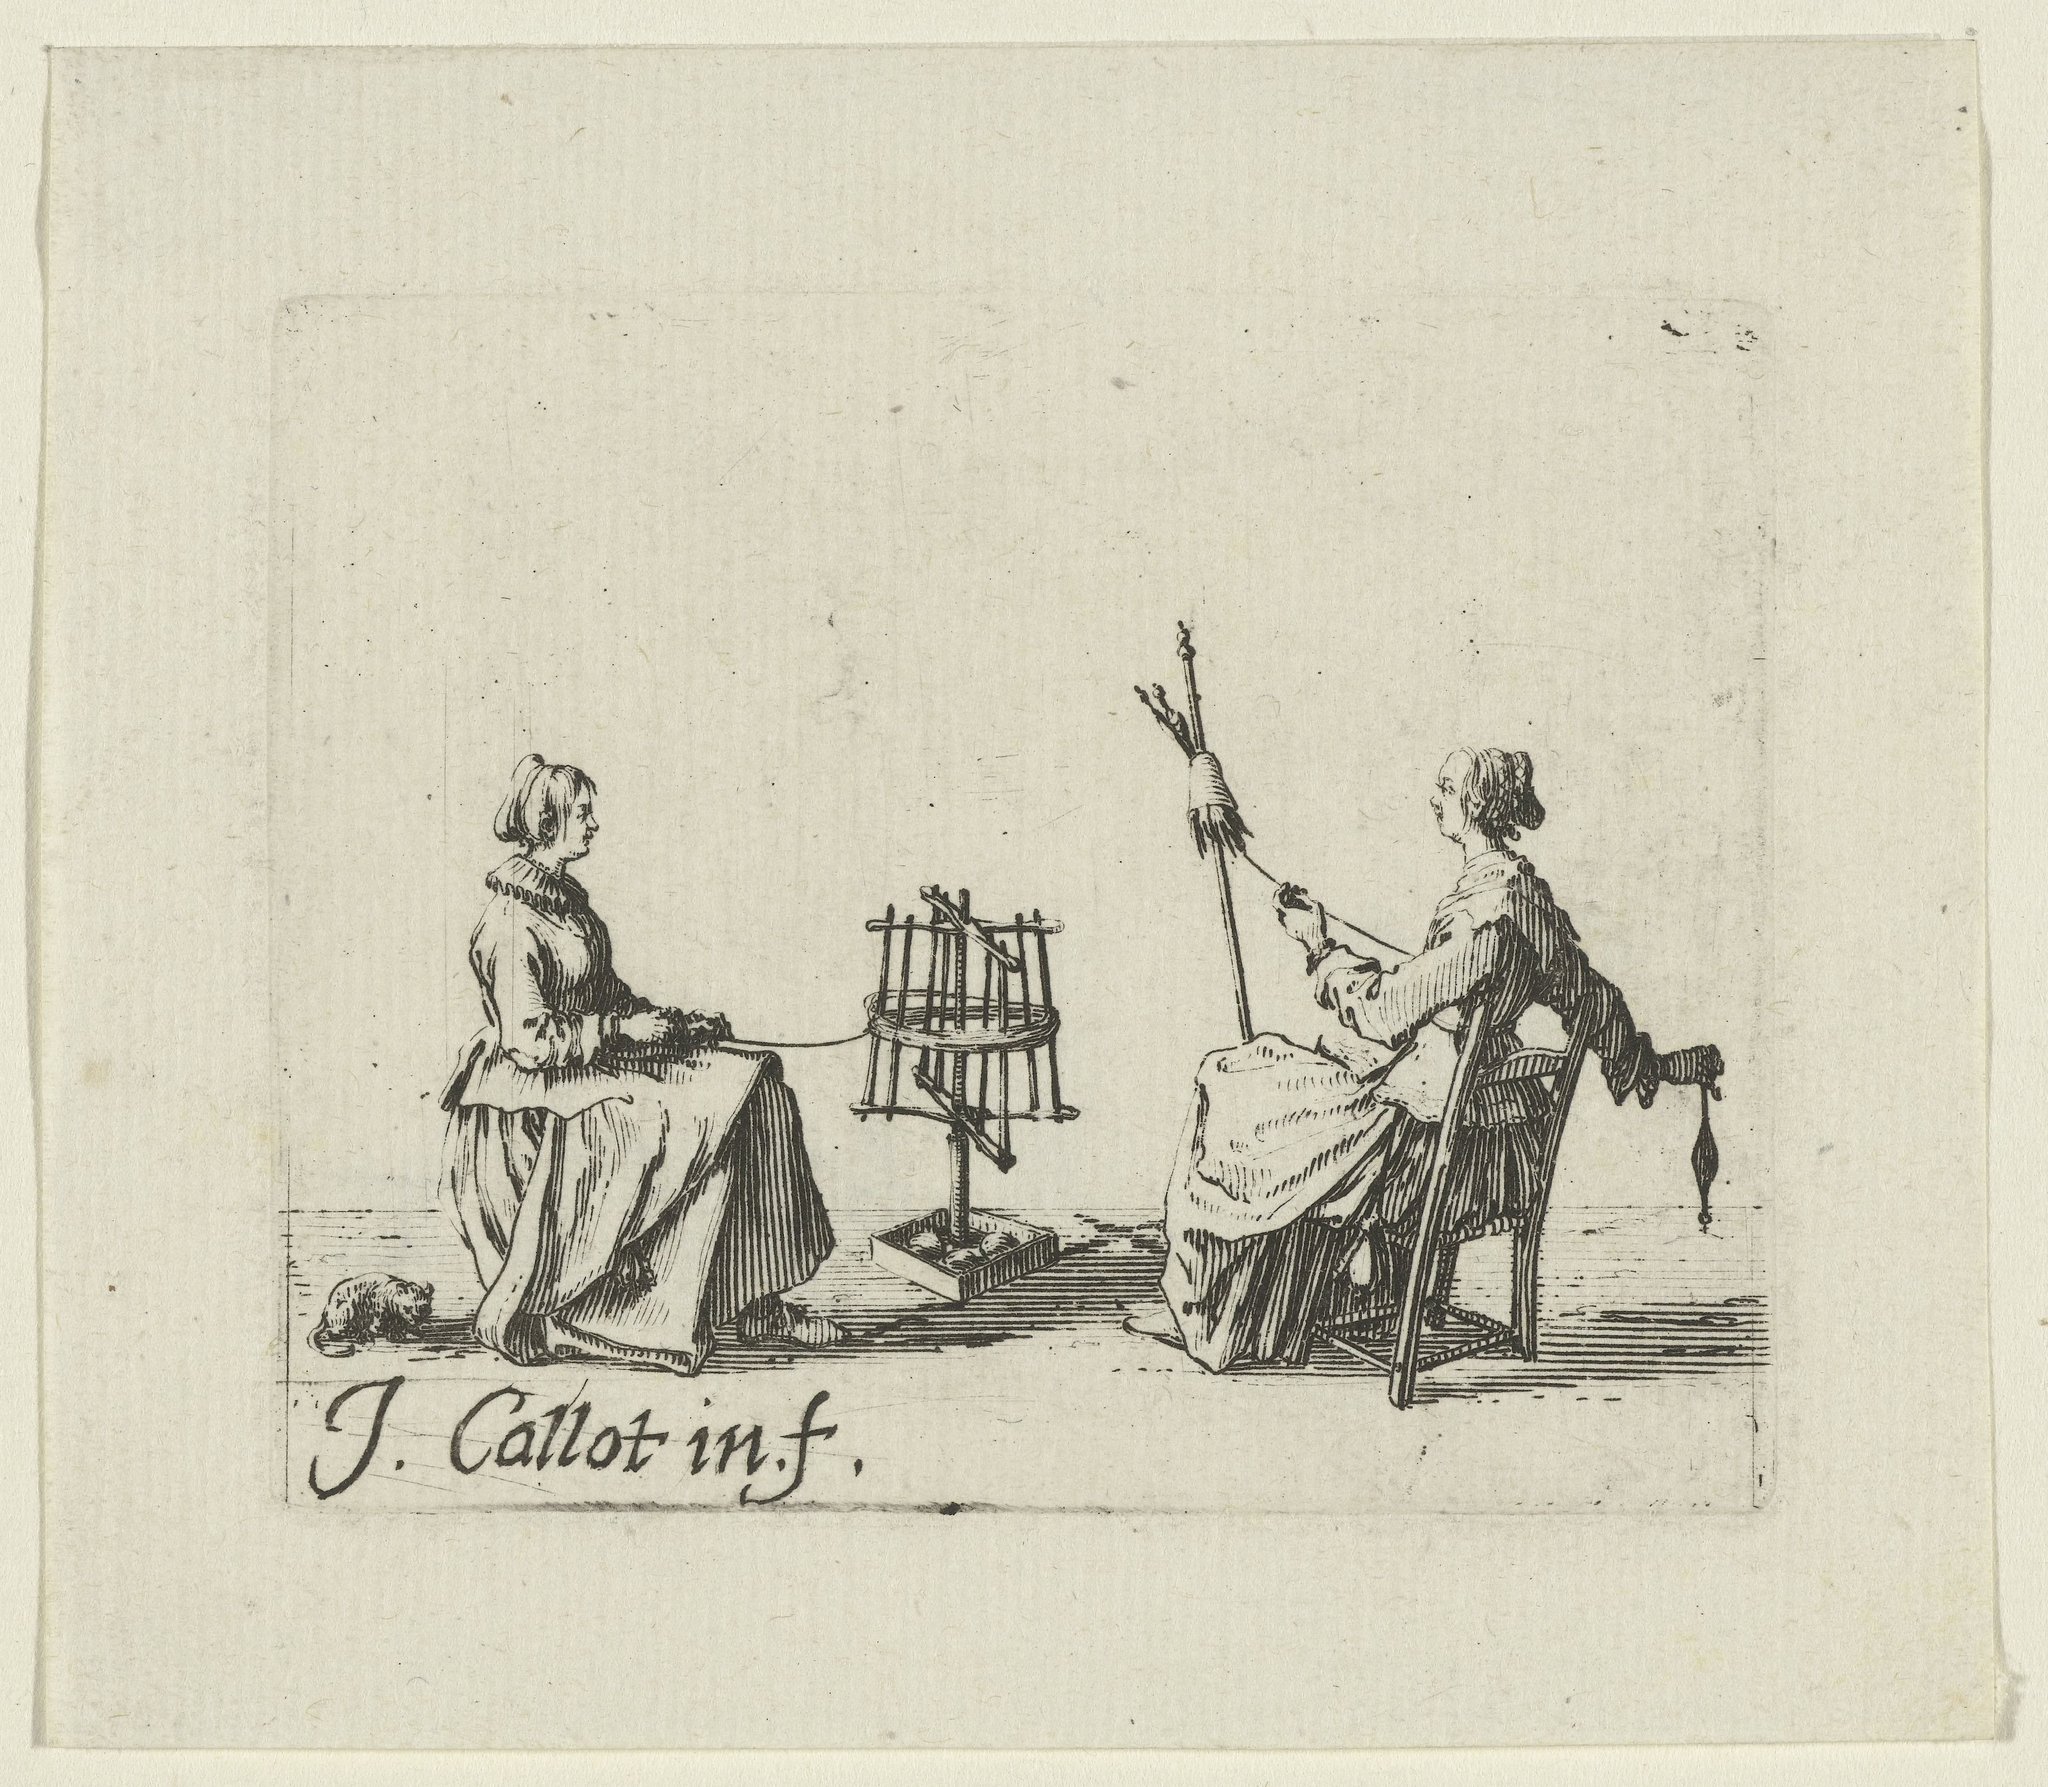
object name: print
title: Garenwindster en spinster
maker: jacques callot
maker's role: draughtsman, print maker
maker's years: 1592-1635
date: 1621-1625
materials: paper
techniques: etching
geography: nancy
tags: distaff, spindle, winding of yarn on reels or spools, reel of yarn, spinning (manufacture of yarn)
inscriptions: collector's mark: Lugt 240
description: Twee vrouwen zitten naast elkaar; de rechter trekt met een klos een draad van een spinrokken, de linker windt een draad van een haspel tot een bol. Pendant van een prent met twee dames van stand.